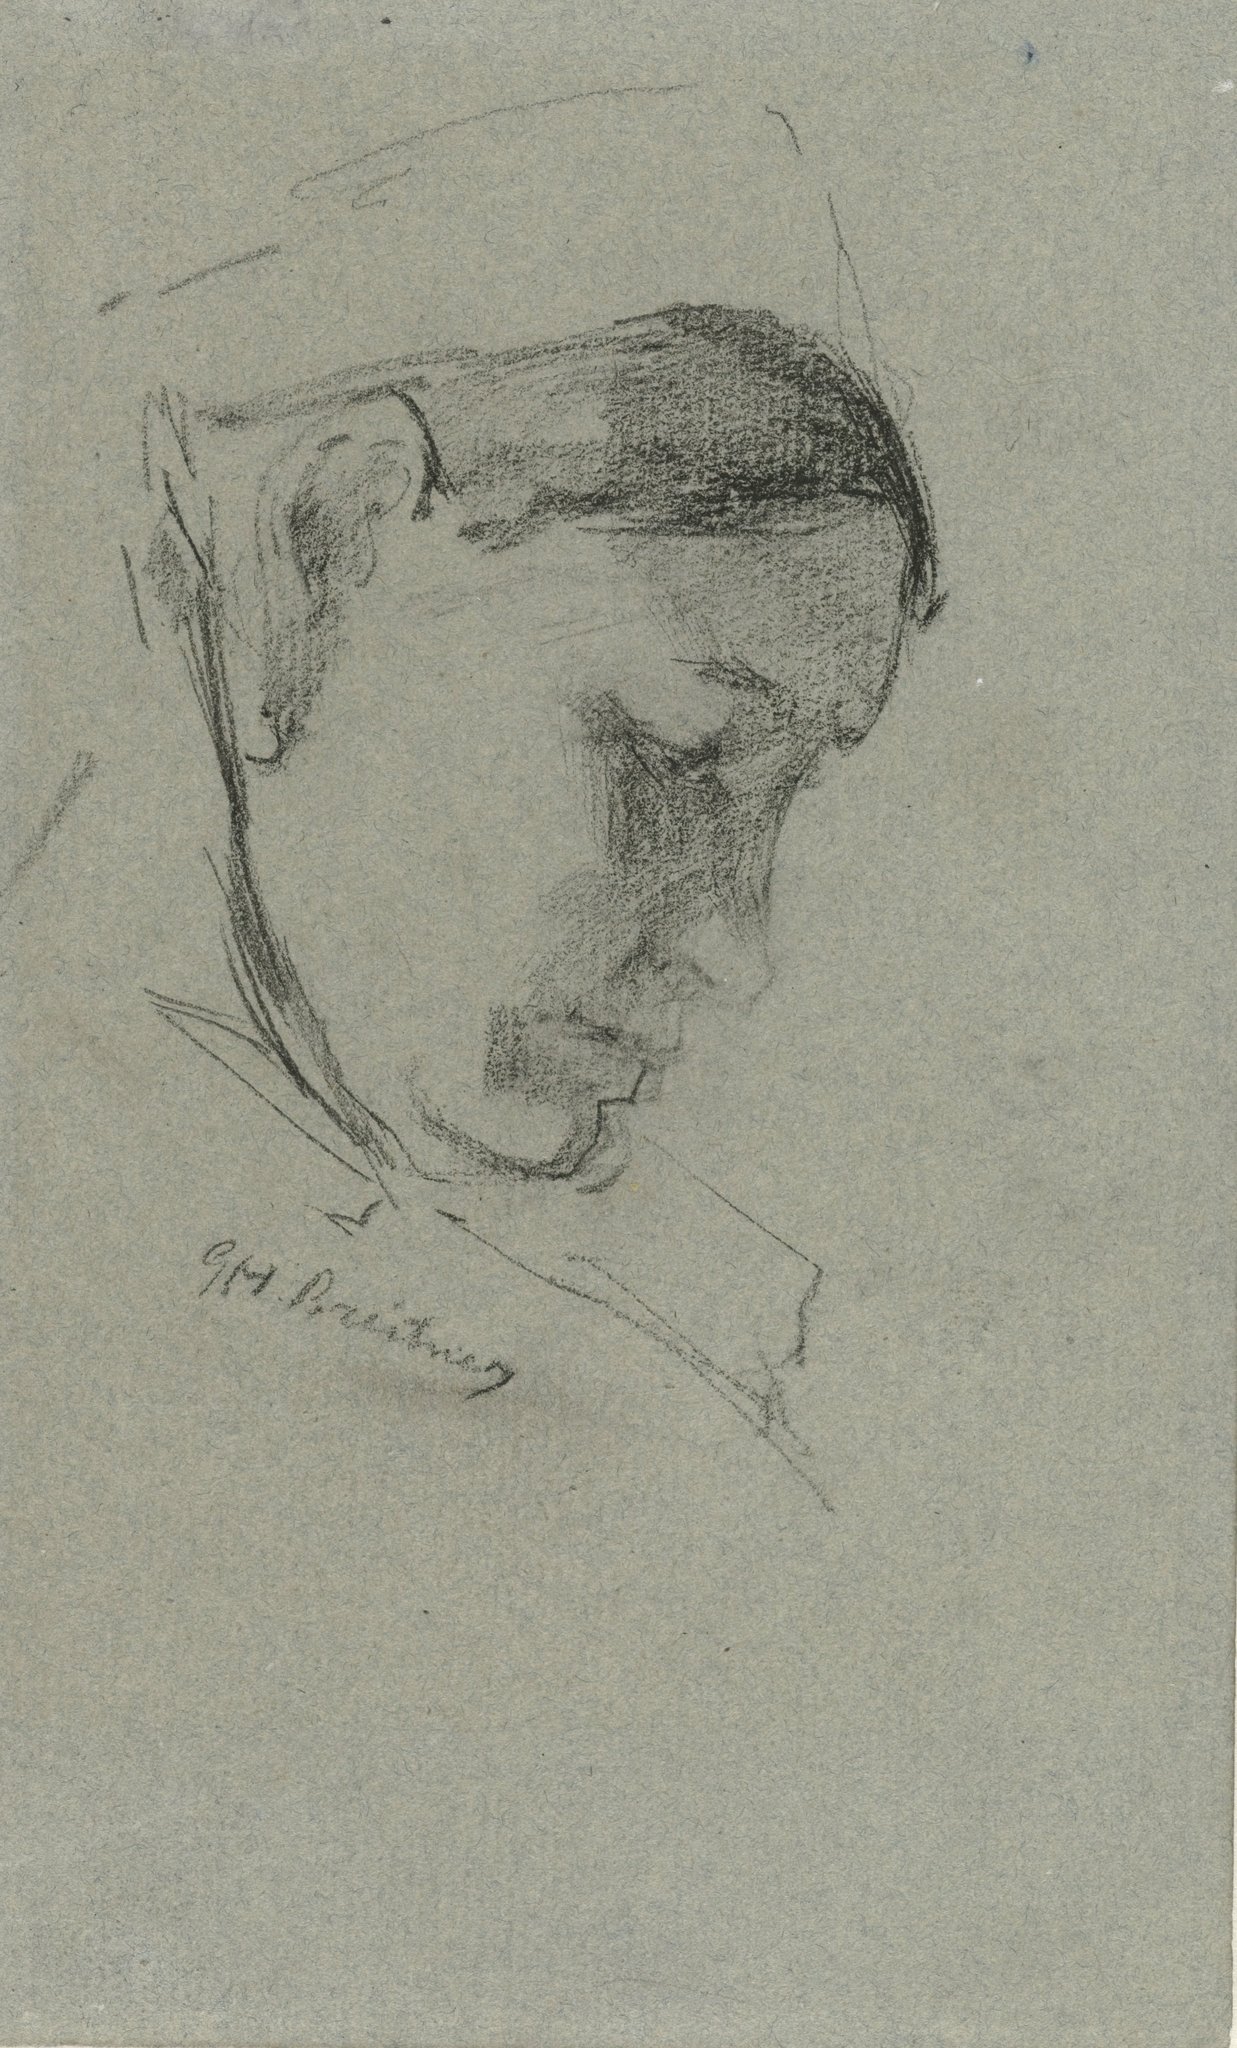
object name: drawing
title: Hoofd van een neerziende vrouw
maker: george hendrik breitner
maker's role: draughtsman, painter, print maker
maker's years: 1857-1923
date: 1867-1923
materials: chalk, paper